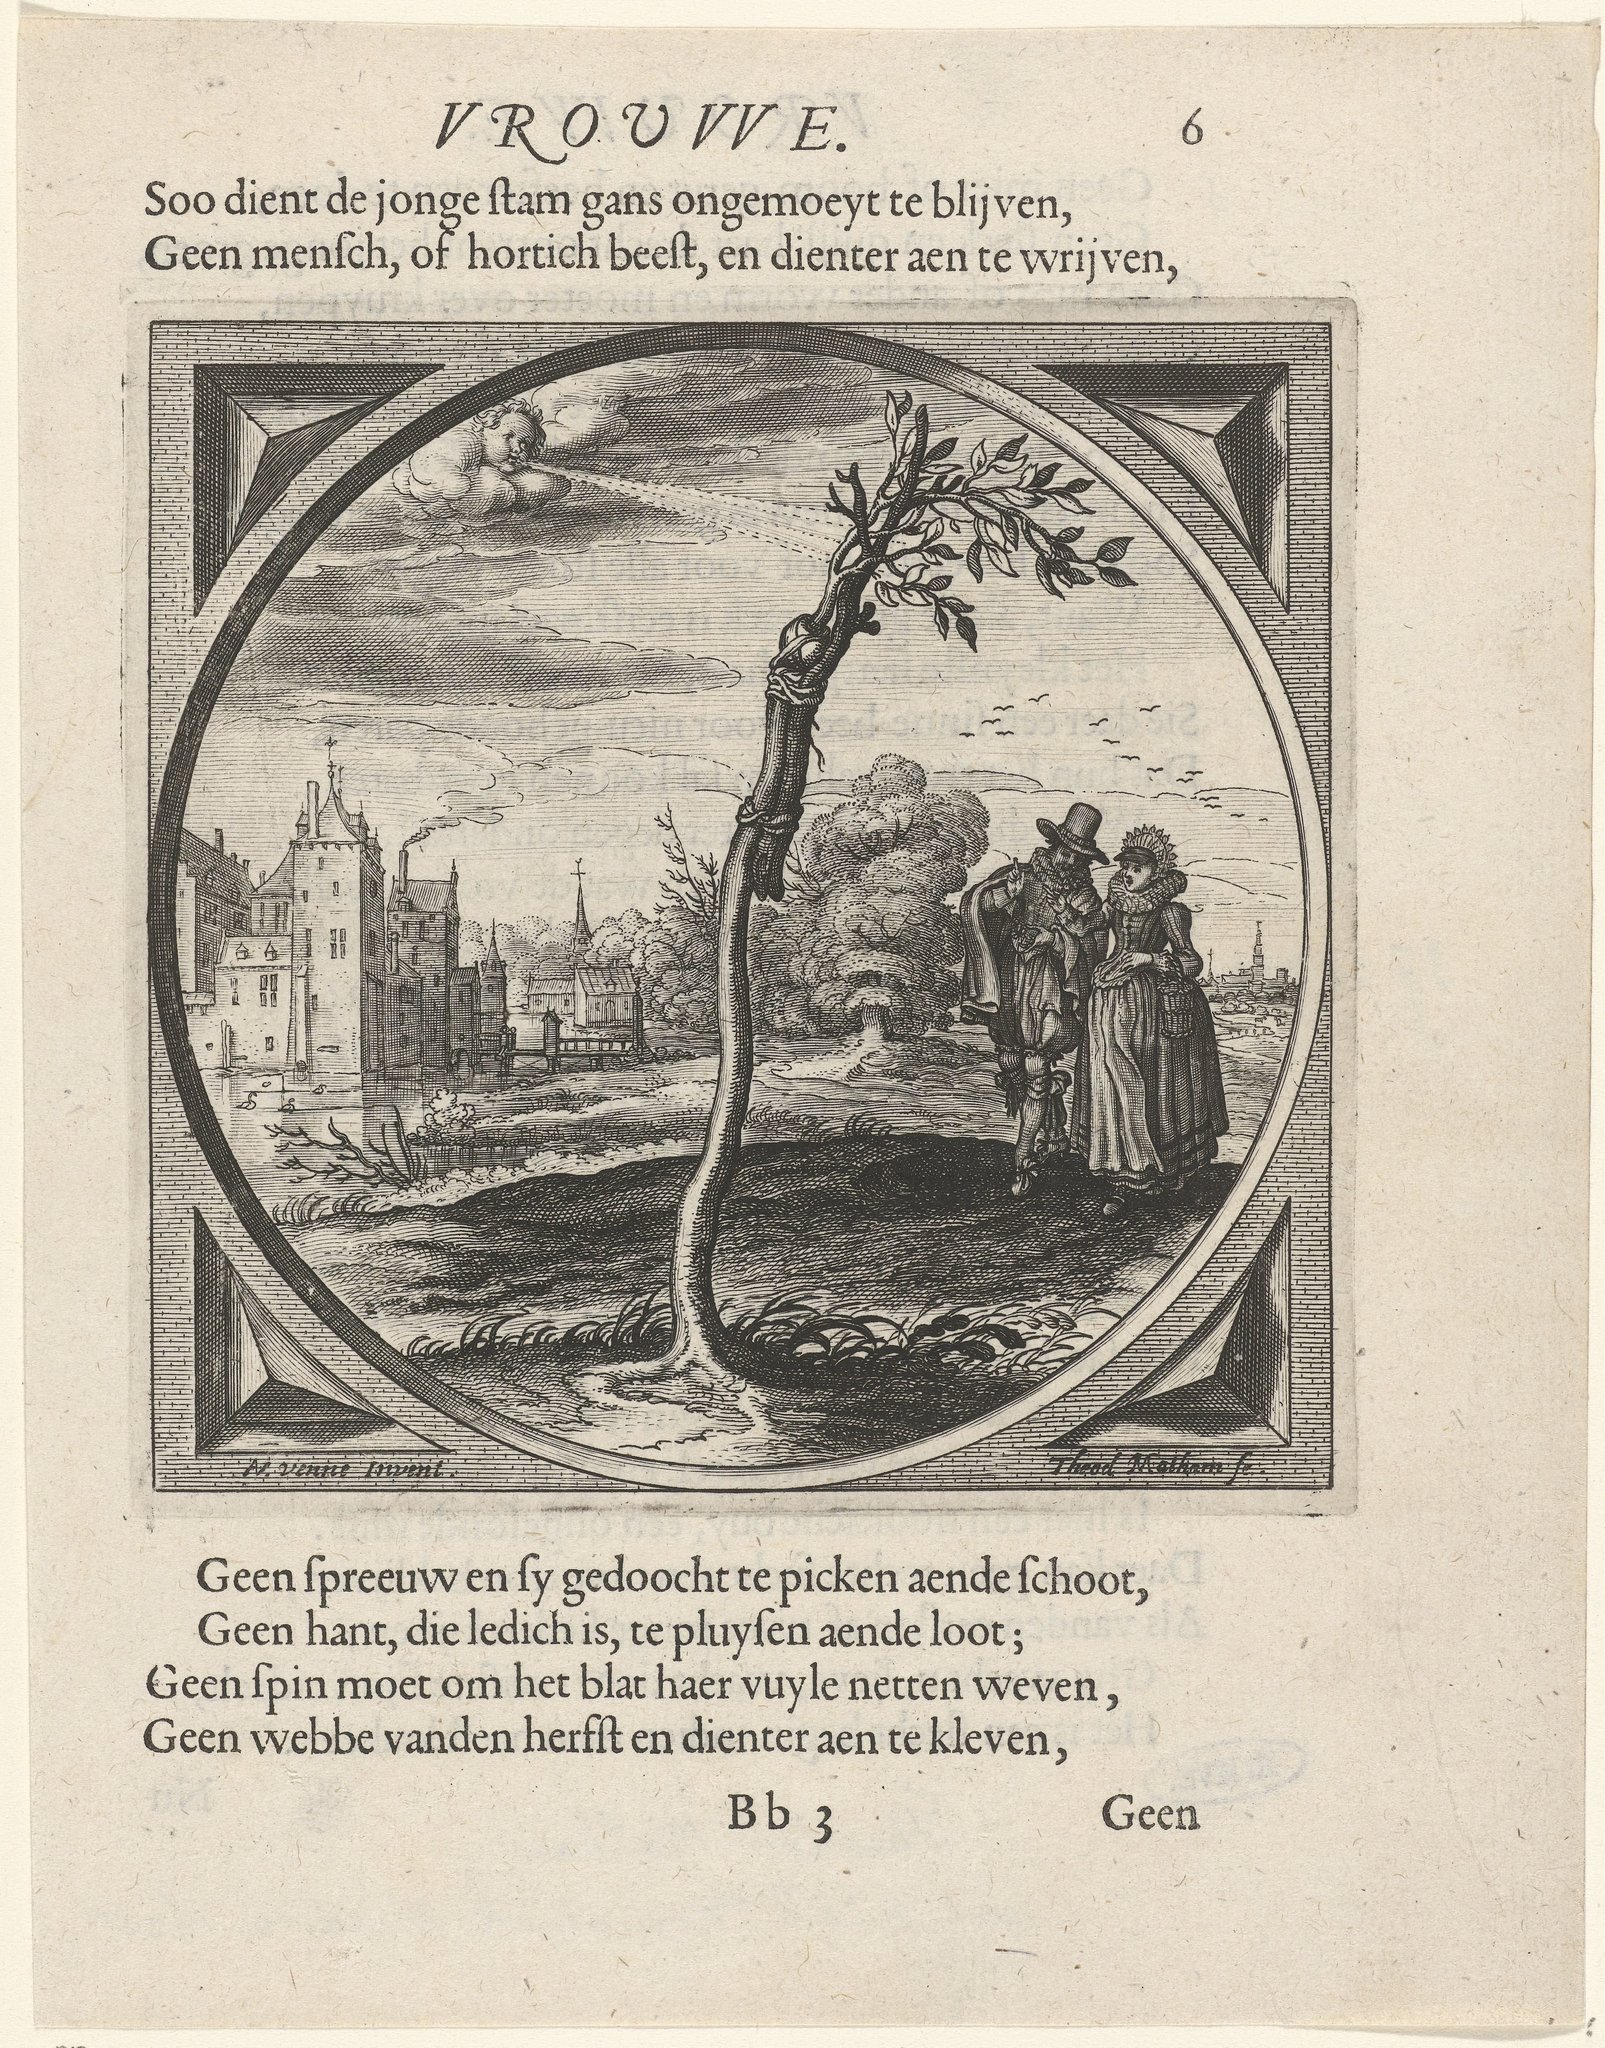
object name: book illustration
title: Man en vrouw bij een jonge boom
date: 1625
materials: paper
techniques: engraving, letterpress printing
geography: middelburg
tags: relations between the sexes, trees (+ plants used symbolically)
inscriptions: collector's mark: Lugt 2228, collector's mark: Lugt 2760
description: Een elegant gekleed paar kijkt naar een jonge boom, waarvan de stam is gebonden aan een tweede tak, om hem recht te laten groeien. Boekillustratie uit: Jacob Cats, Houwelijck, 1625.